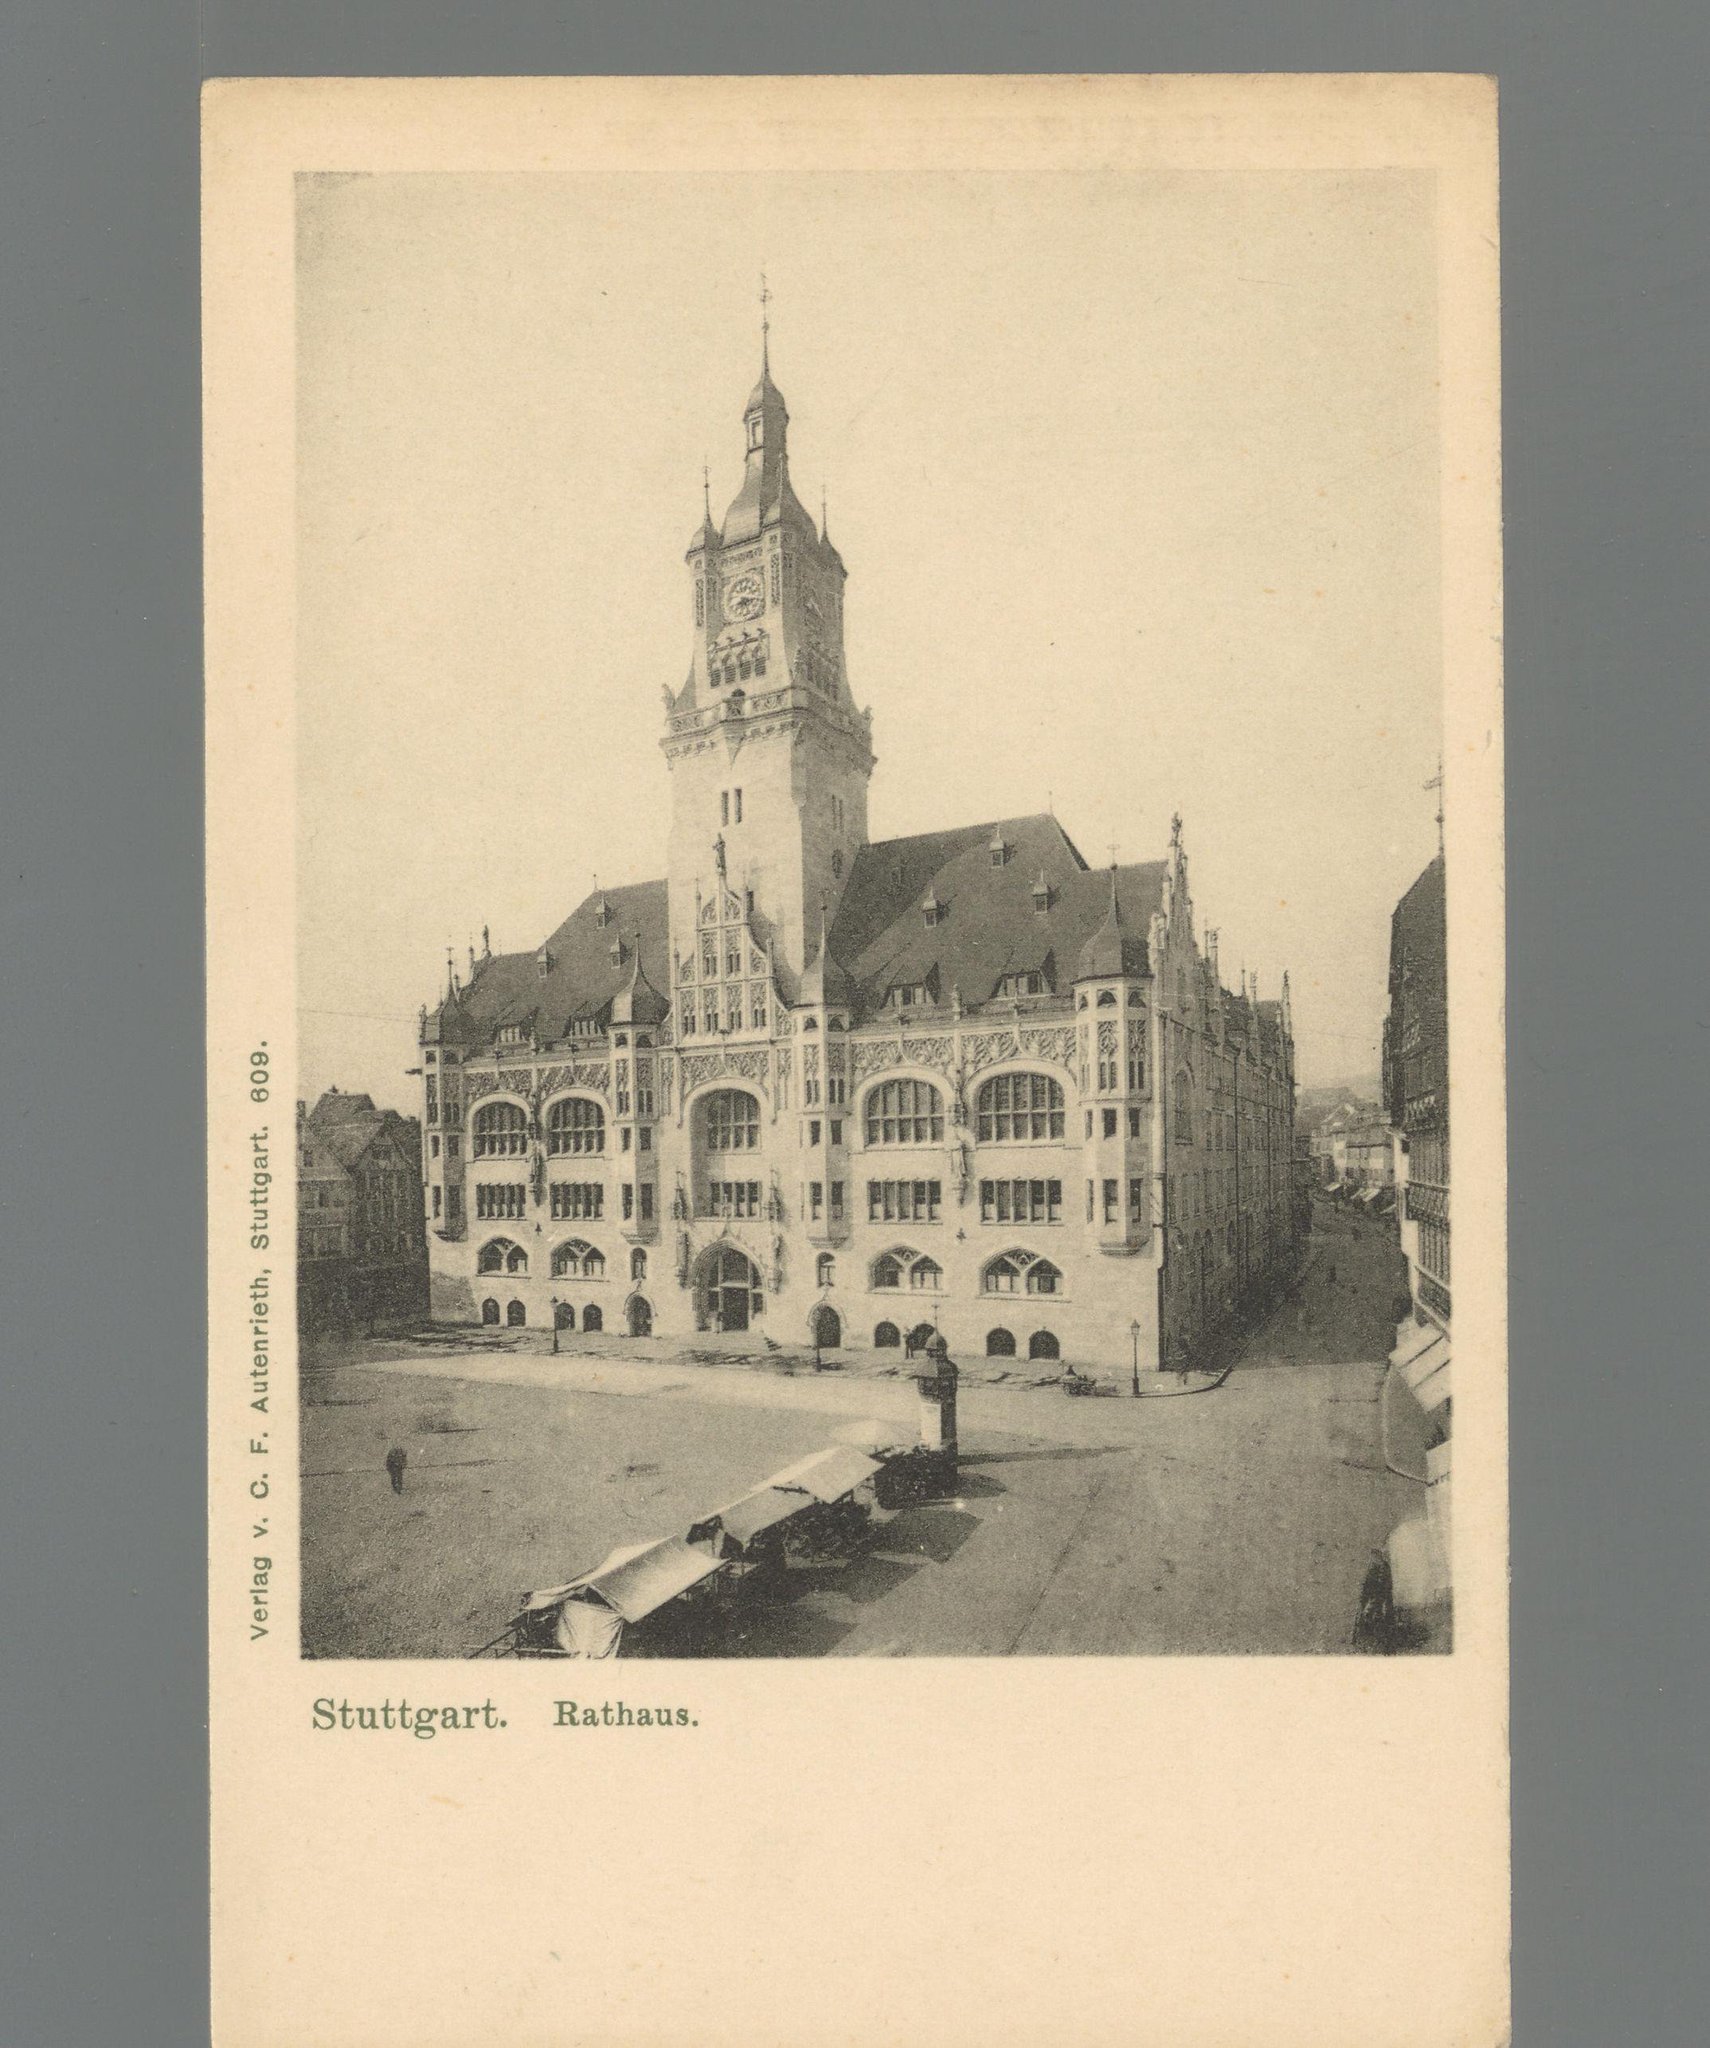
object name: photomechanical print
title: Stuttgart. Rathaus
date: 1905-1930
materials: cardboard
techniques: photograph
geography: stuttgart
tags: square, place, circus, etc., townhall